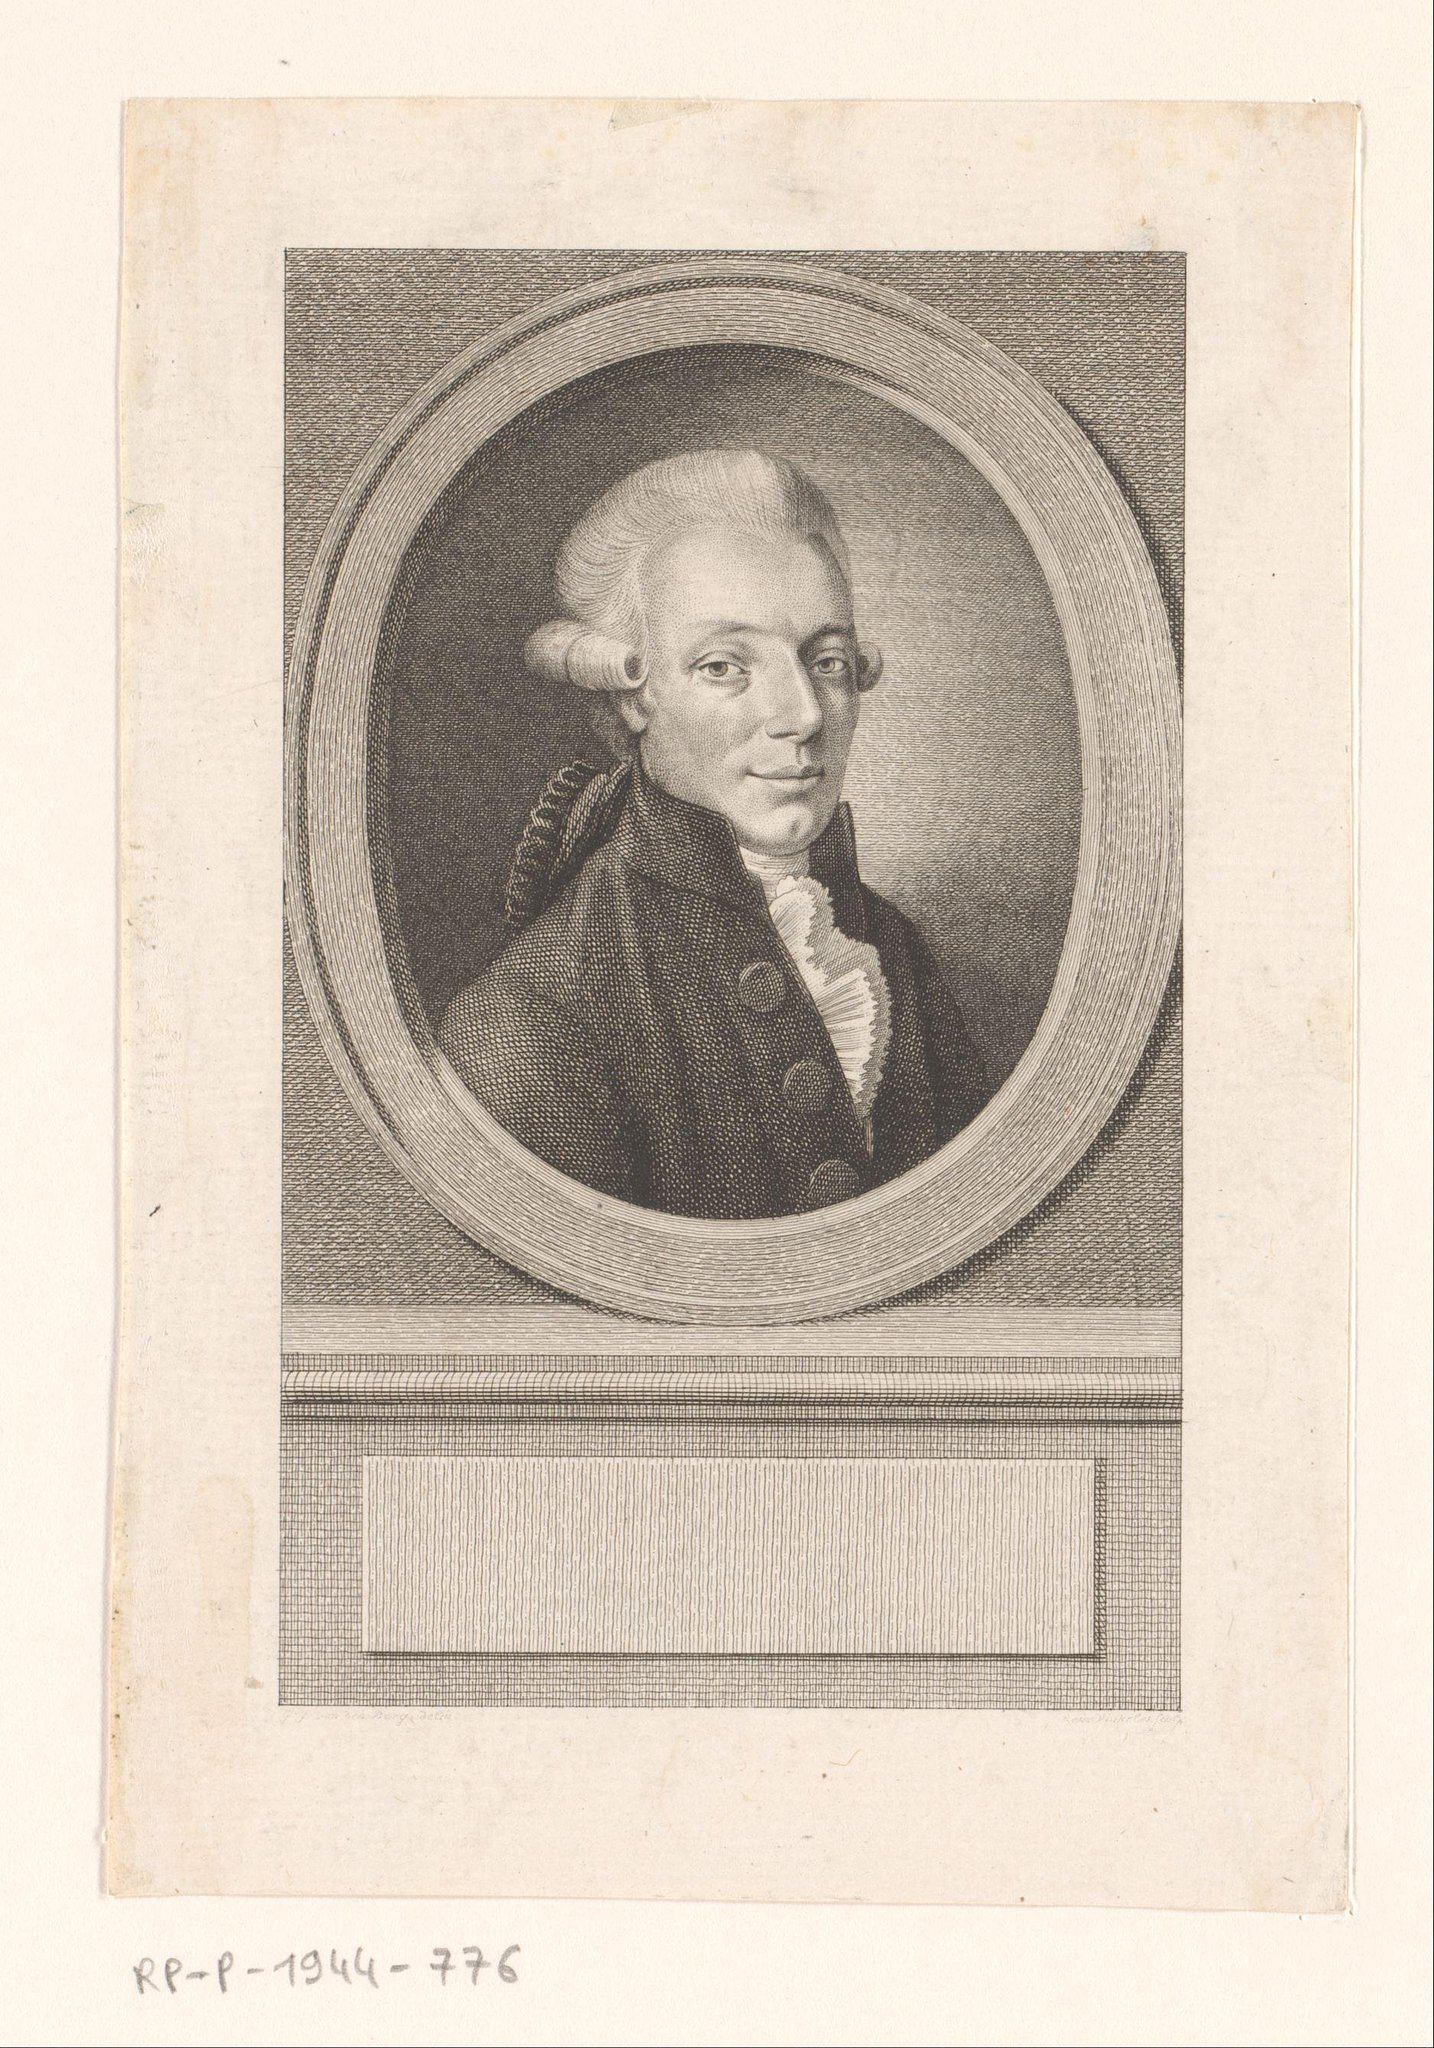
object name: print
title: Portret van Pieter Paulus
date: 1792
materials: paper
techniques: etching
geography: amsterdam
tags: the hague, pieter paulus, ornament ~ medallion, historical persons, politician, e.g. party leader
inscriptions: inscription: ‘Reeds in Franken aanwezig/ Gm’, collector's mark: Lugt 2228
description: Latere staat van prent gebruikt in: Loosjes, Petrus Adriaanszoon. Vaderlandsche historie, (...) ten vervolge van Wagenaars Vaderlandsche historie. Amsterdam: Johannes Allart, 1792, dl. 9.